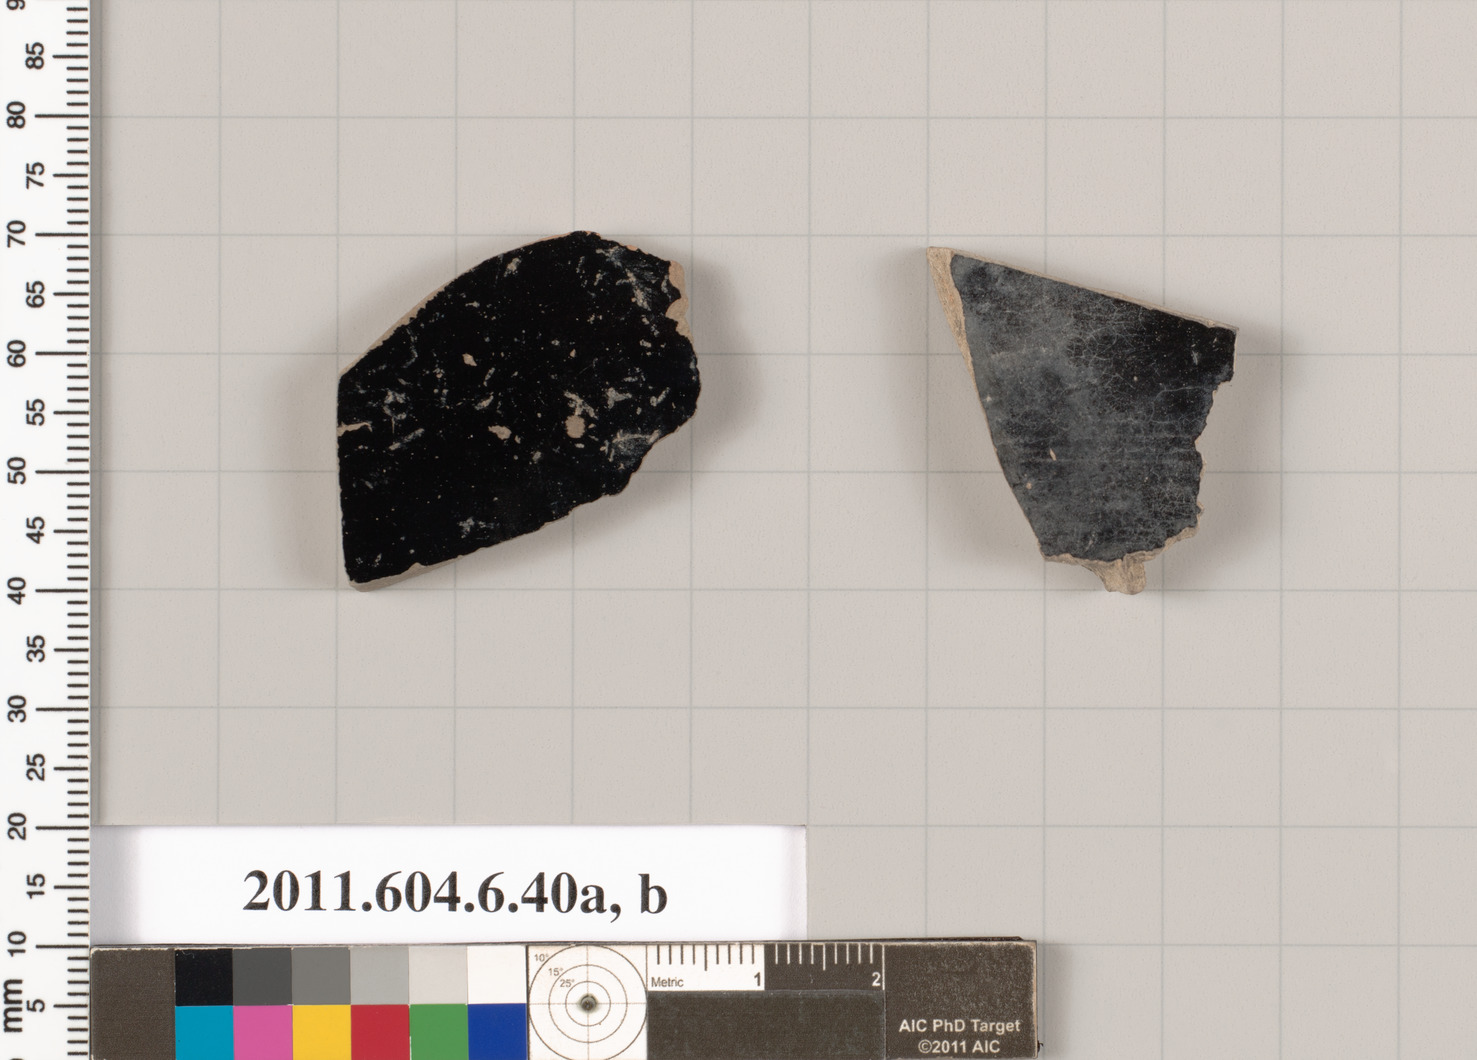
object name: undetermined closed shape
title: Terracotta fragments of closed shapes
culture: greek, attic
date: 600-401 BCE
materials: terracotta